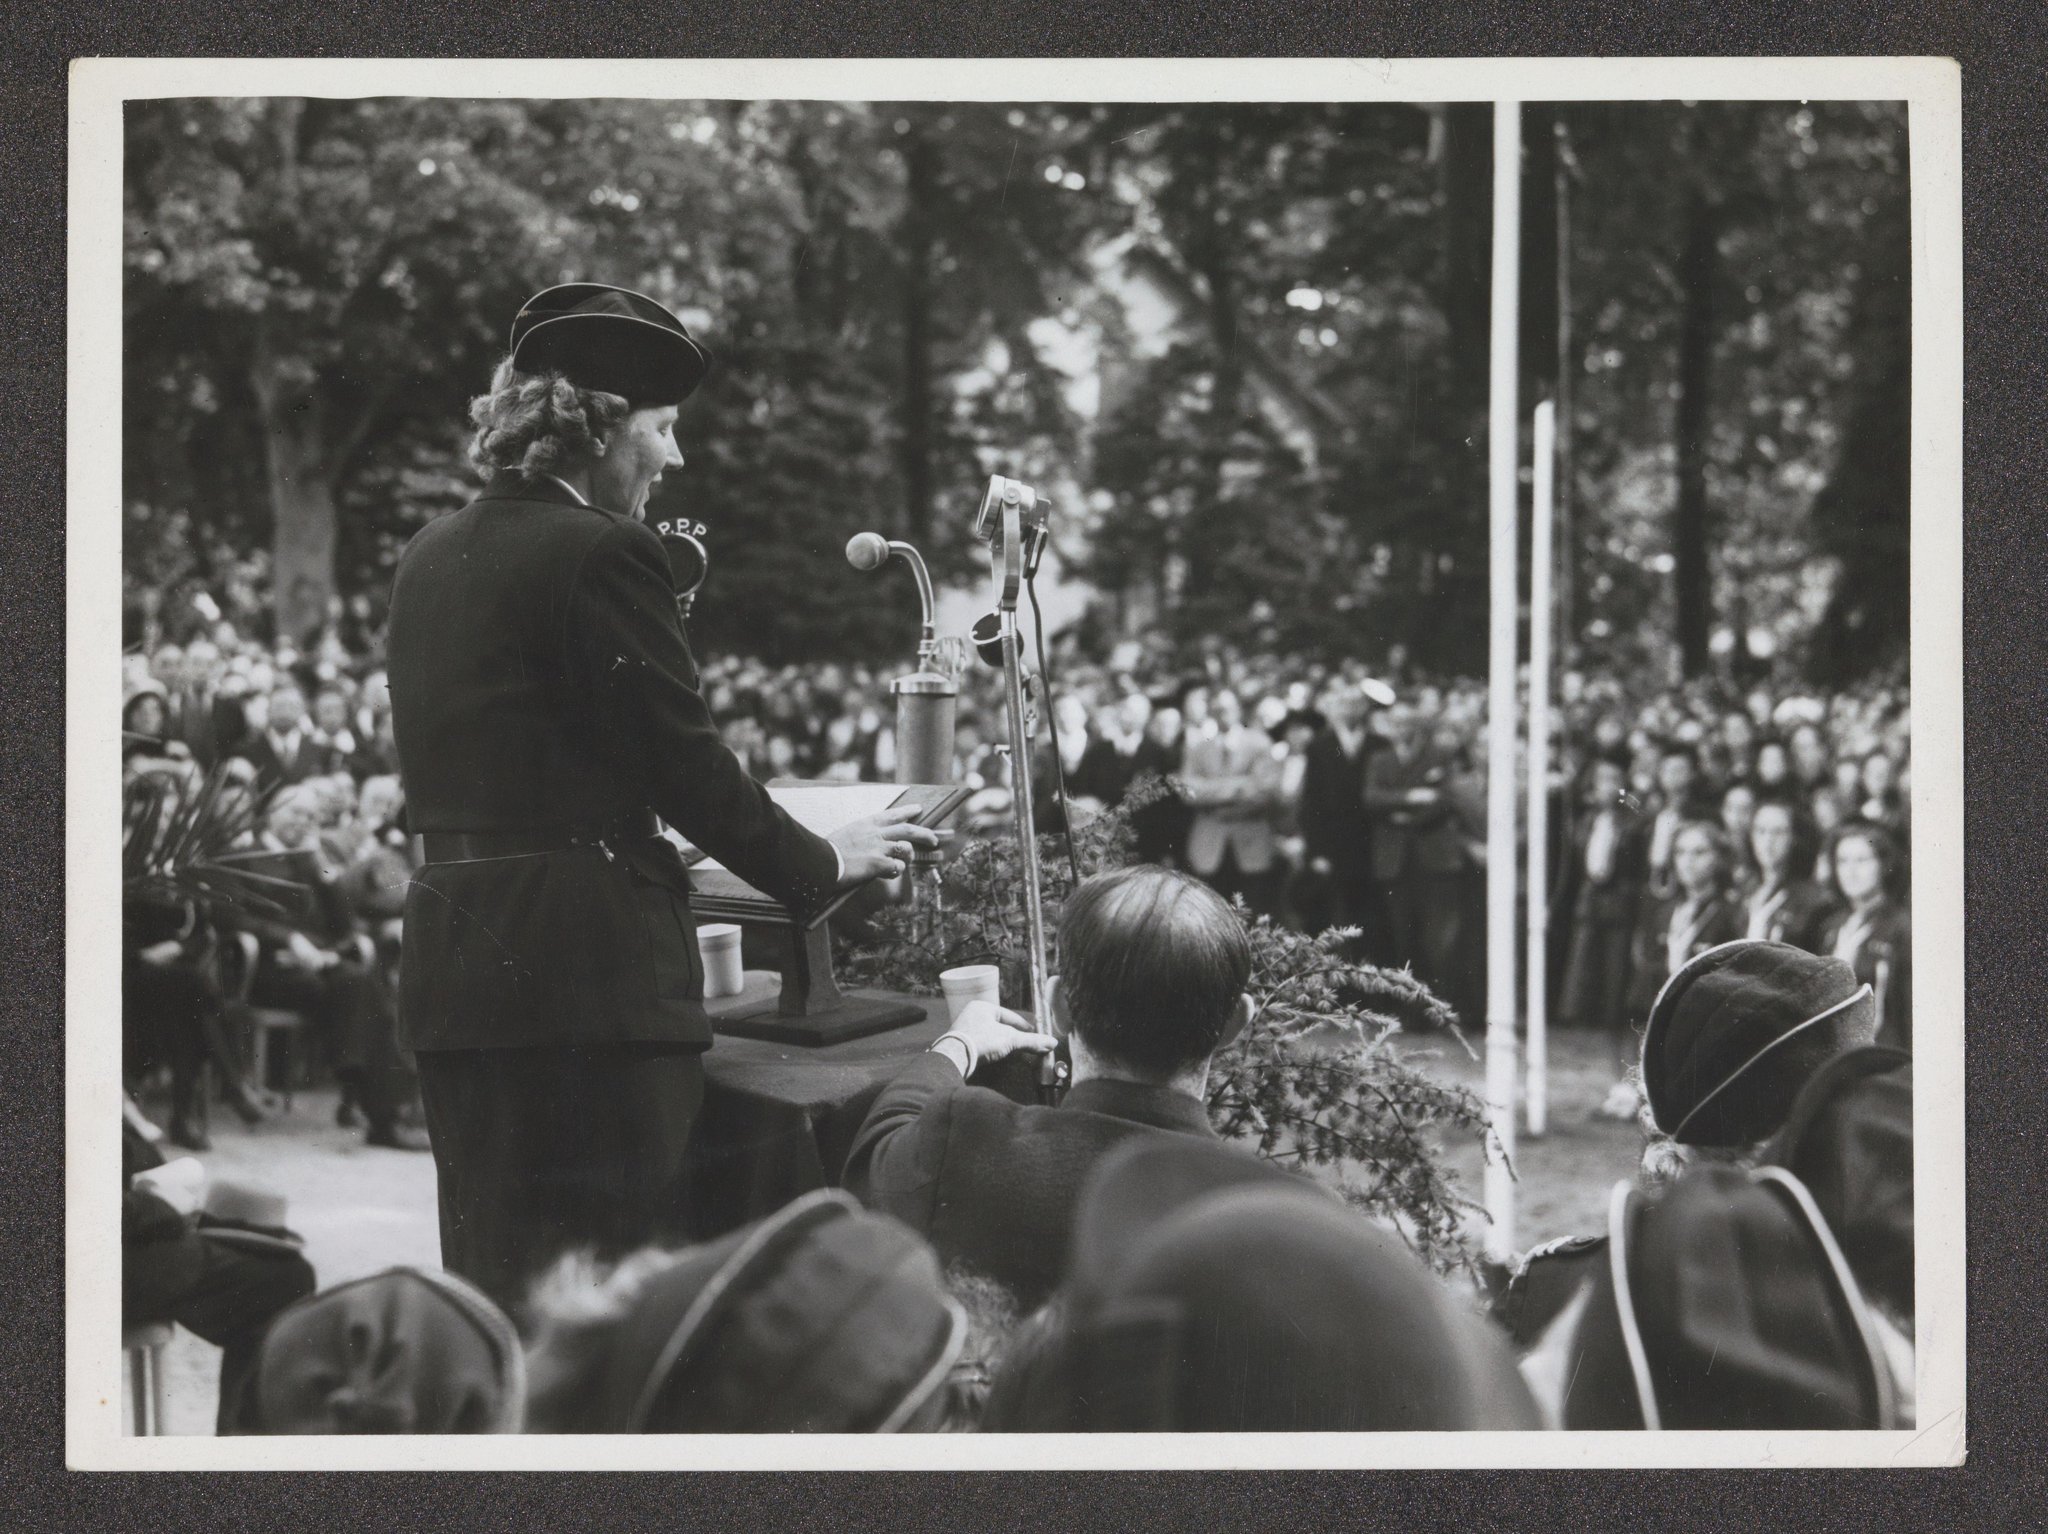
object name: photograph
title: Koningin Juliana in uniform geeft een toespraak ten overstaan van een scouting bijeenkomst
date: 1949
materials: paper, photographic support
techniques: gelatin silver print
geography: netherlands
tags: juliana of the netherlands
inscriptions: annotation: ‘Opening Nederlands Padvindersgilde-Centrum Buitenzorg te Baarn door H.M. Koningin Juliana. De openingsrede van H.M. Koningin Juliana. Foto - Anefo 25-6-49 34491’